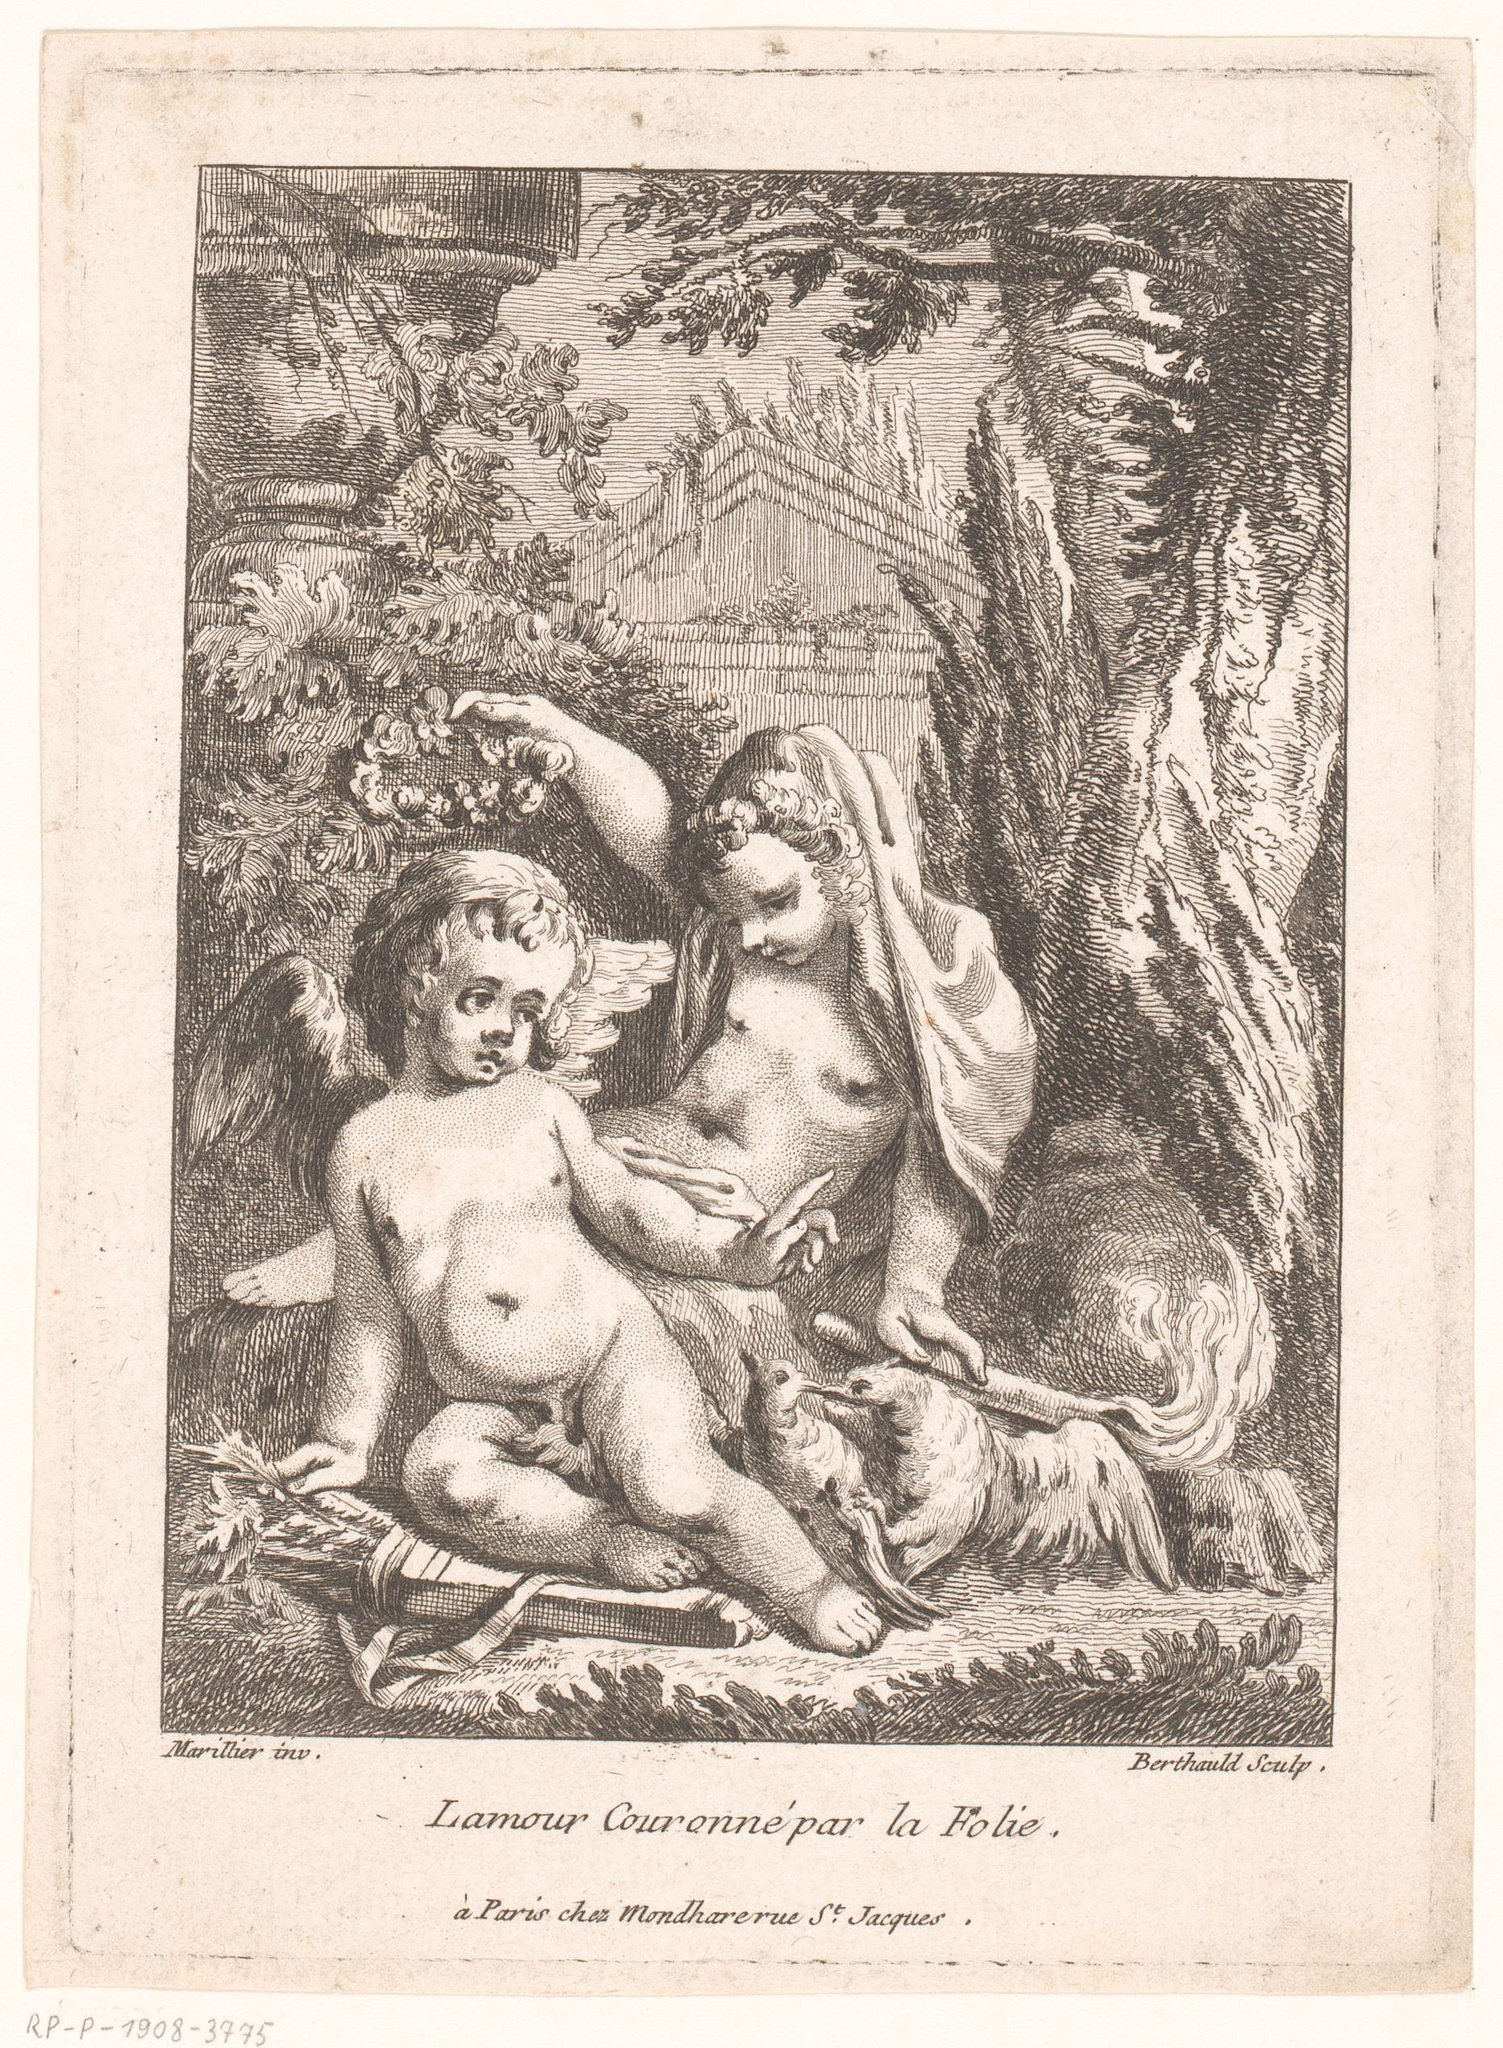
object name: print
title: Lamour Couronné par la Folie.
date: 1750-1819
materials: paper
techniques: etching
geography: france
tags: love personified, folly, foolishness; 'pazzia', 'sciocchezza', 'stoltitia' (ripa), cupids: 'amores', 'amoretti', 'putti'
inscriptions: collector's mark: Lugt 2228